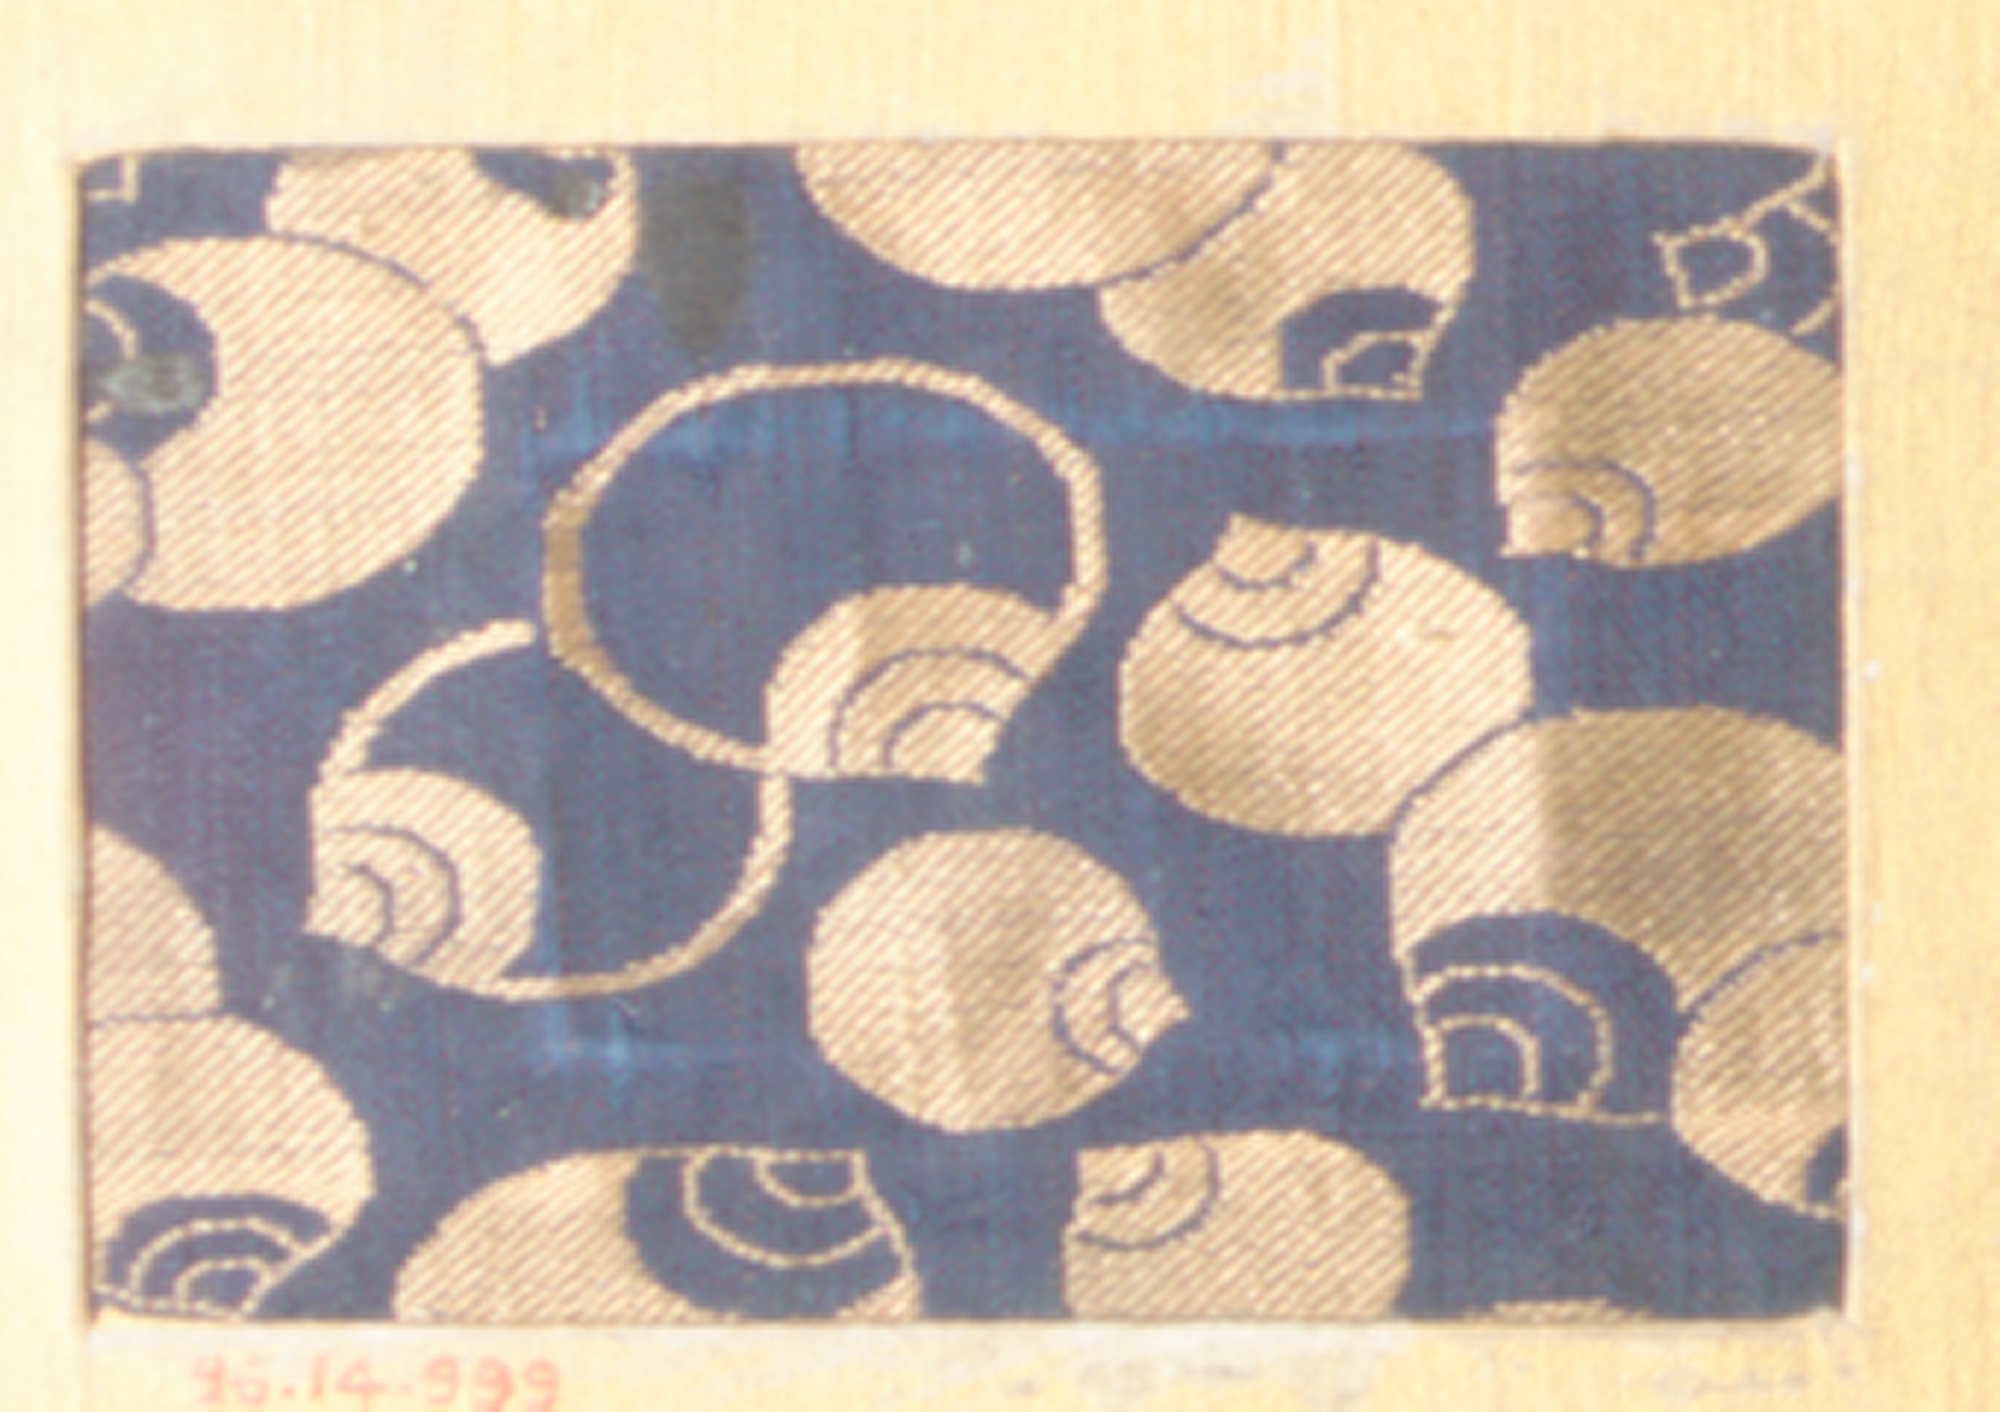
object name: piece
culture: japanese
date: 1701-1900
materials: silk